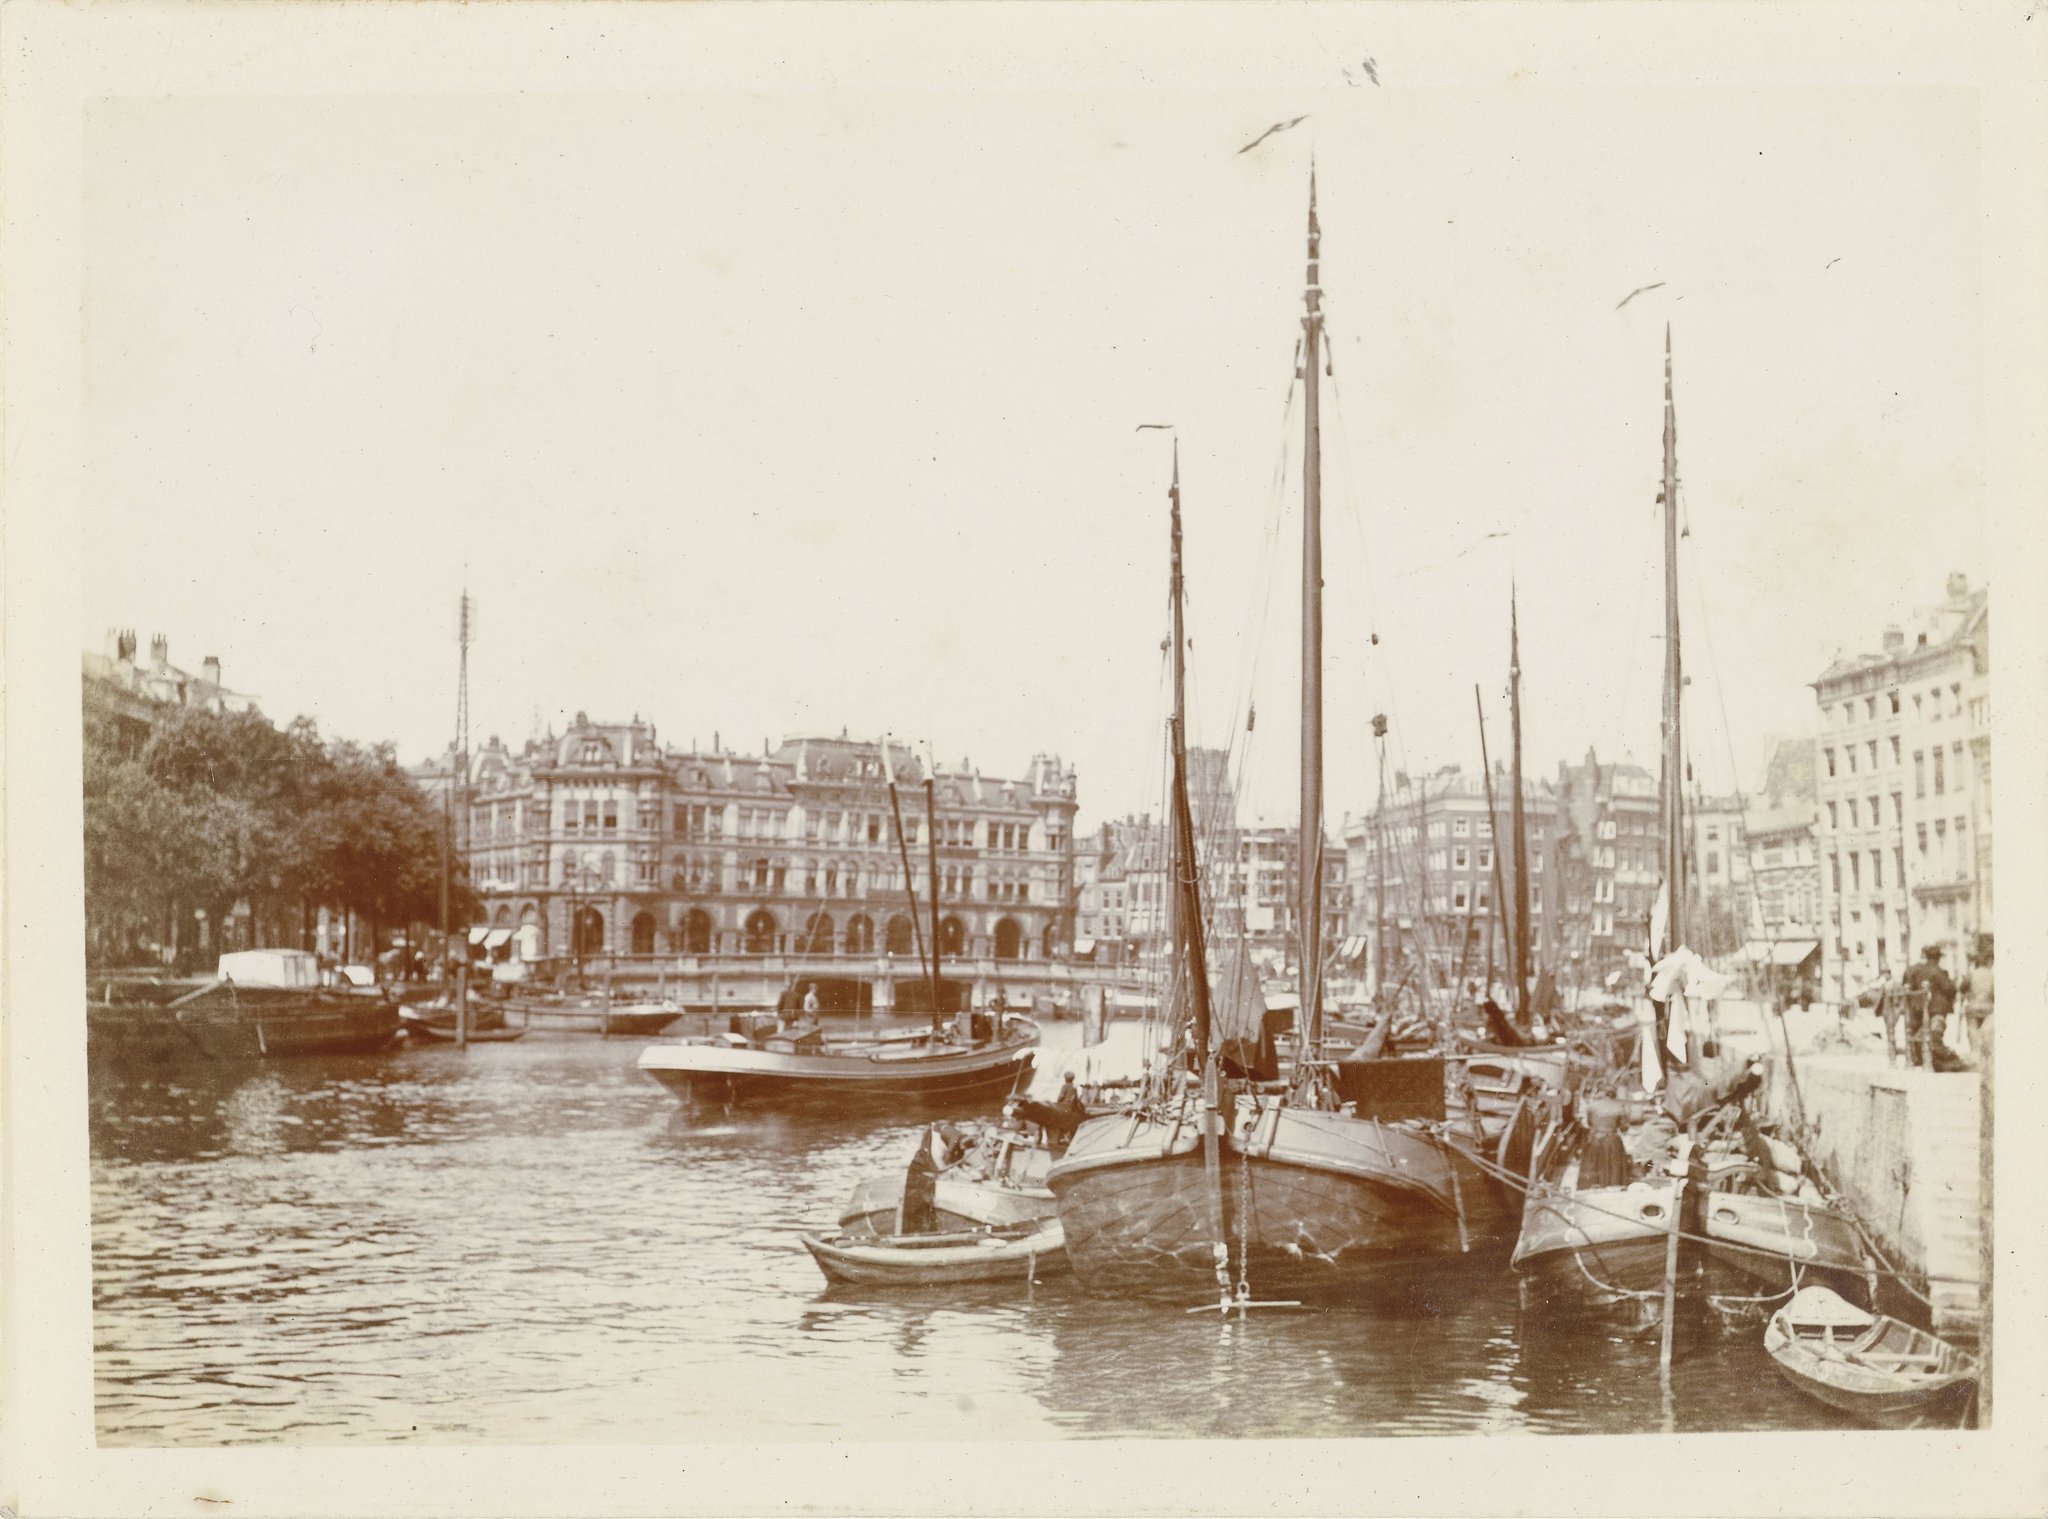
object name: photograph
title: Gezicht op de Oudehaven van Rotterdam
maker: james higson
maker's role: politician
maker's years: 1862-1933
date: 1904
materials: paper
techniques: gelatin silver print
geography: rotterdam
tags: harbour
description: Gezicht op de Oudehaven van Rotterdam met op de achtergrond bedrijfsverzamelgebouw Plan C.